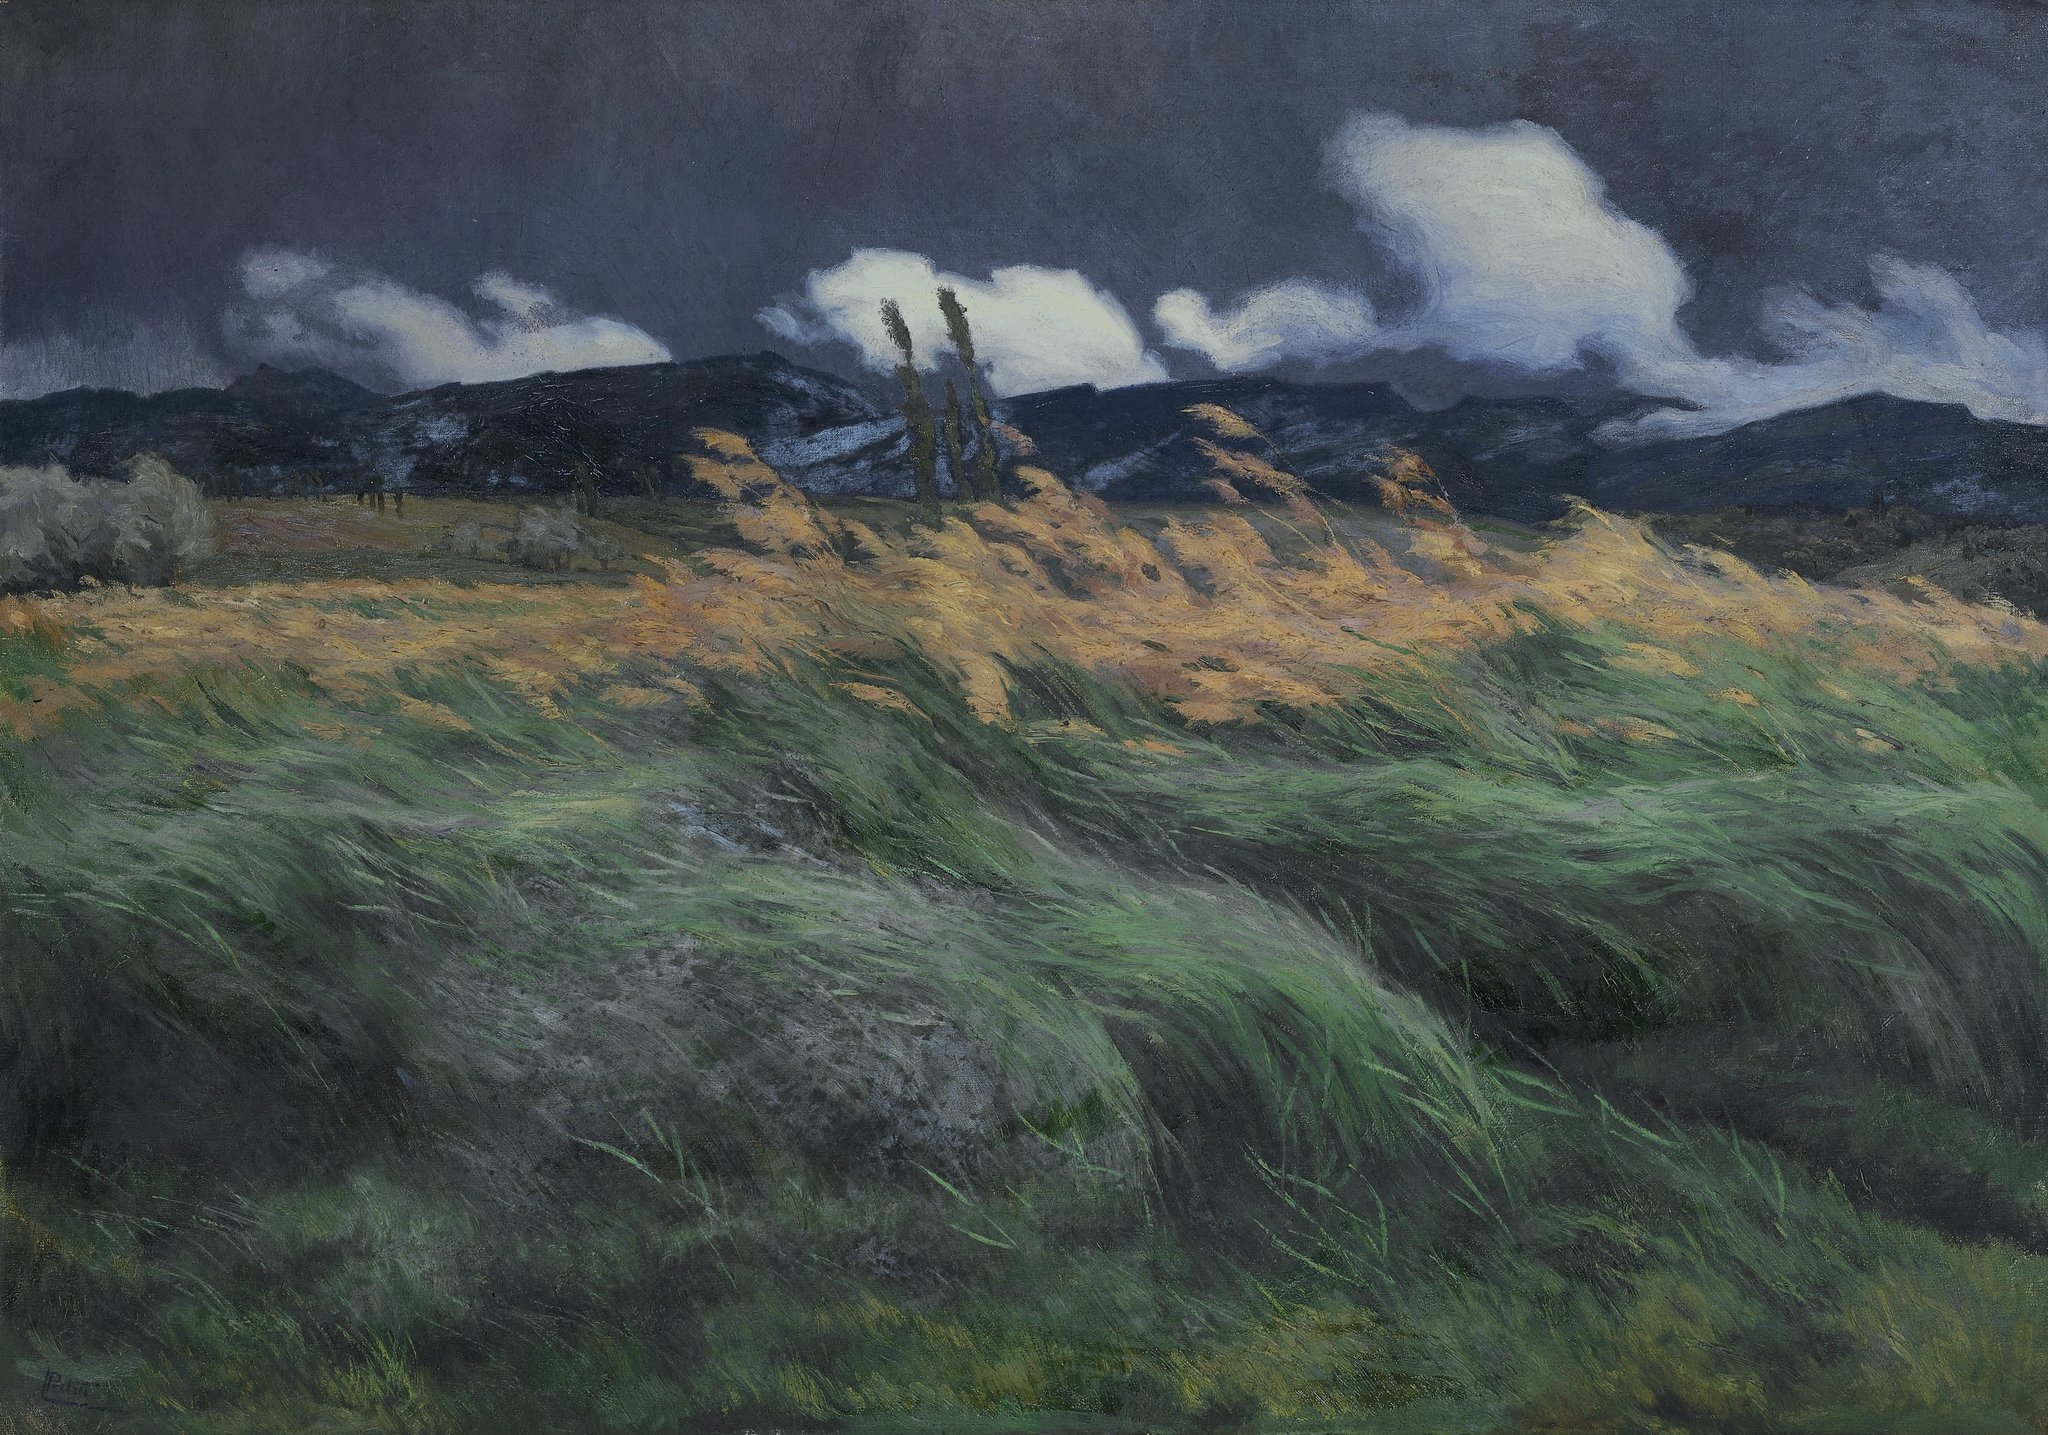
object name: painting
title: Landschap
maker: louis patru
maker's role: painter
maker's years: 1871-1905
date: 1895-1905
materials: canvas, oil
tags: landscapes in the temperate zone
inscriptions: signature: ‘LPatru’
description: Landschap met wuivend gras of koren, in de verte een bergketen.